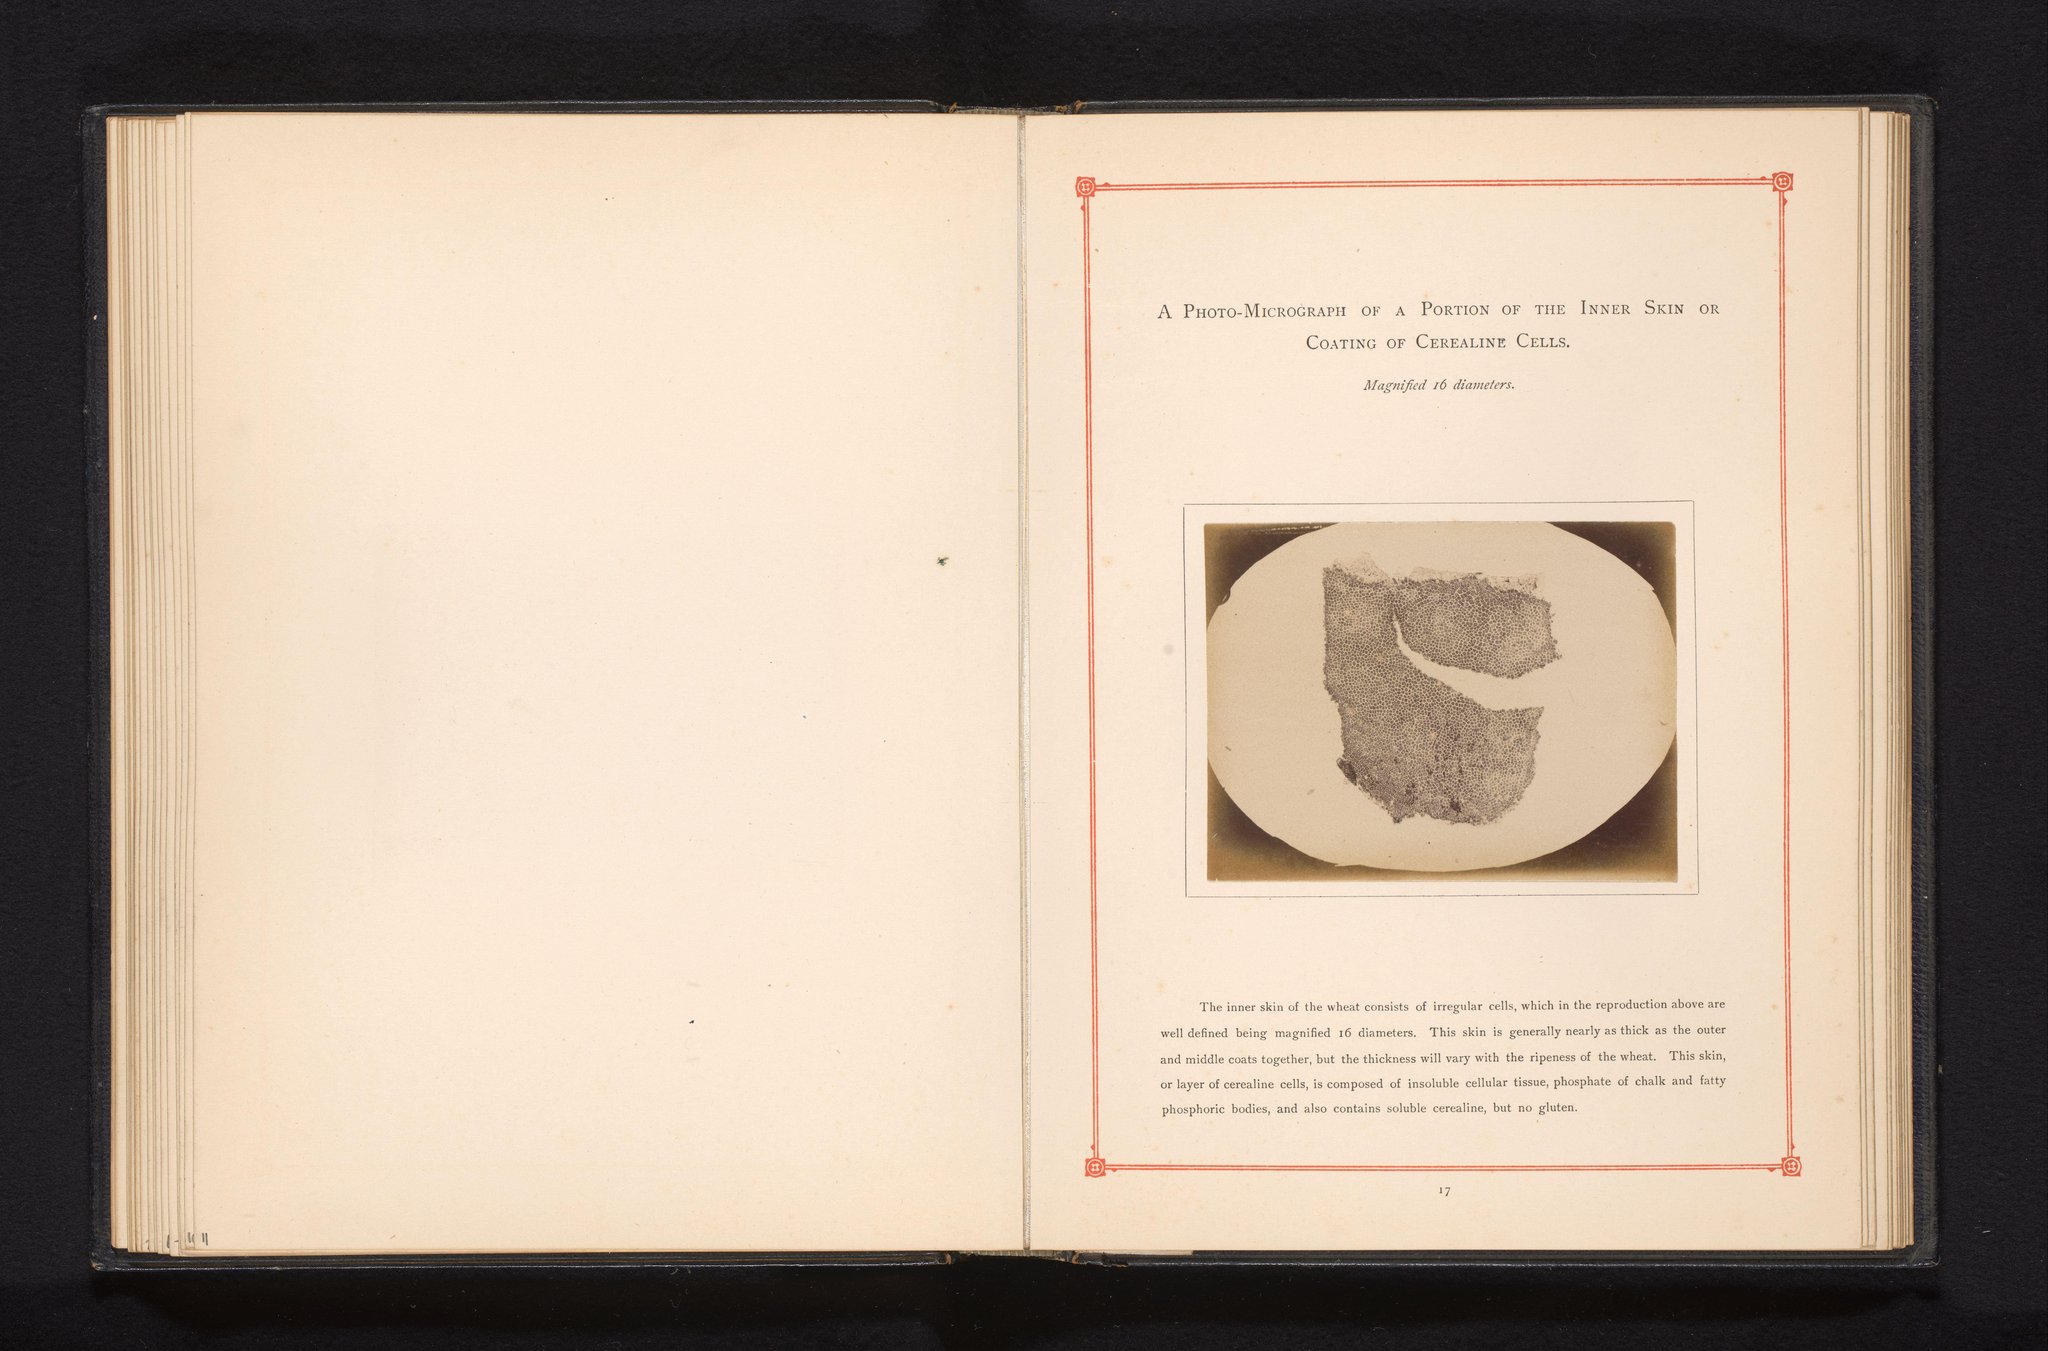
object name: photograph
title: Microscoopopname van de kern van een tarweplant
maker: robert w. dunham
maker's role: fotograaf, wetenschapper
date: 1882-1892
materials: photographic support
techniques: albumen print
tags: plants and herbs: wheat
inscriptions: inscription: ‘Magnified 16 diameters.’